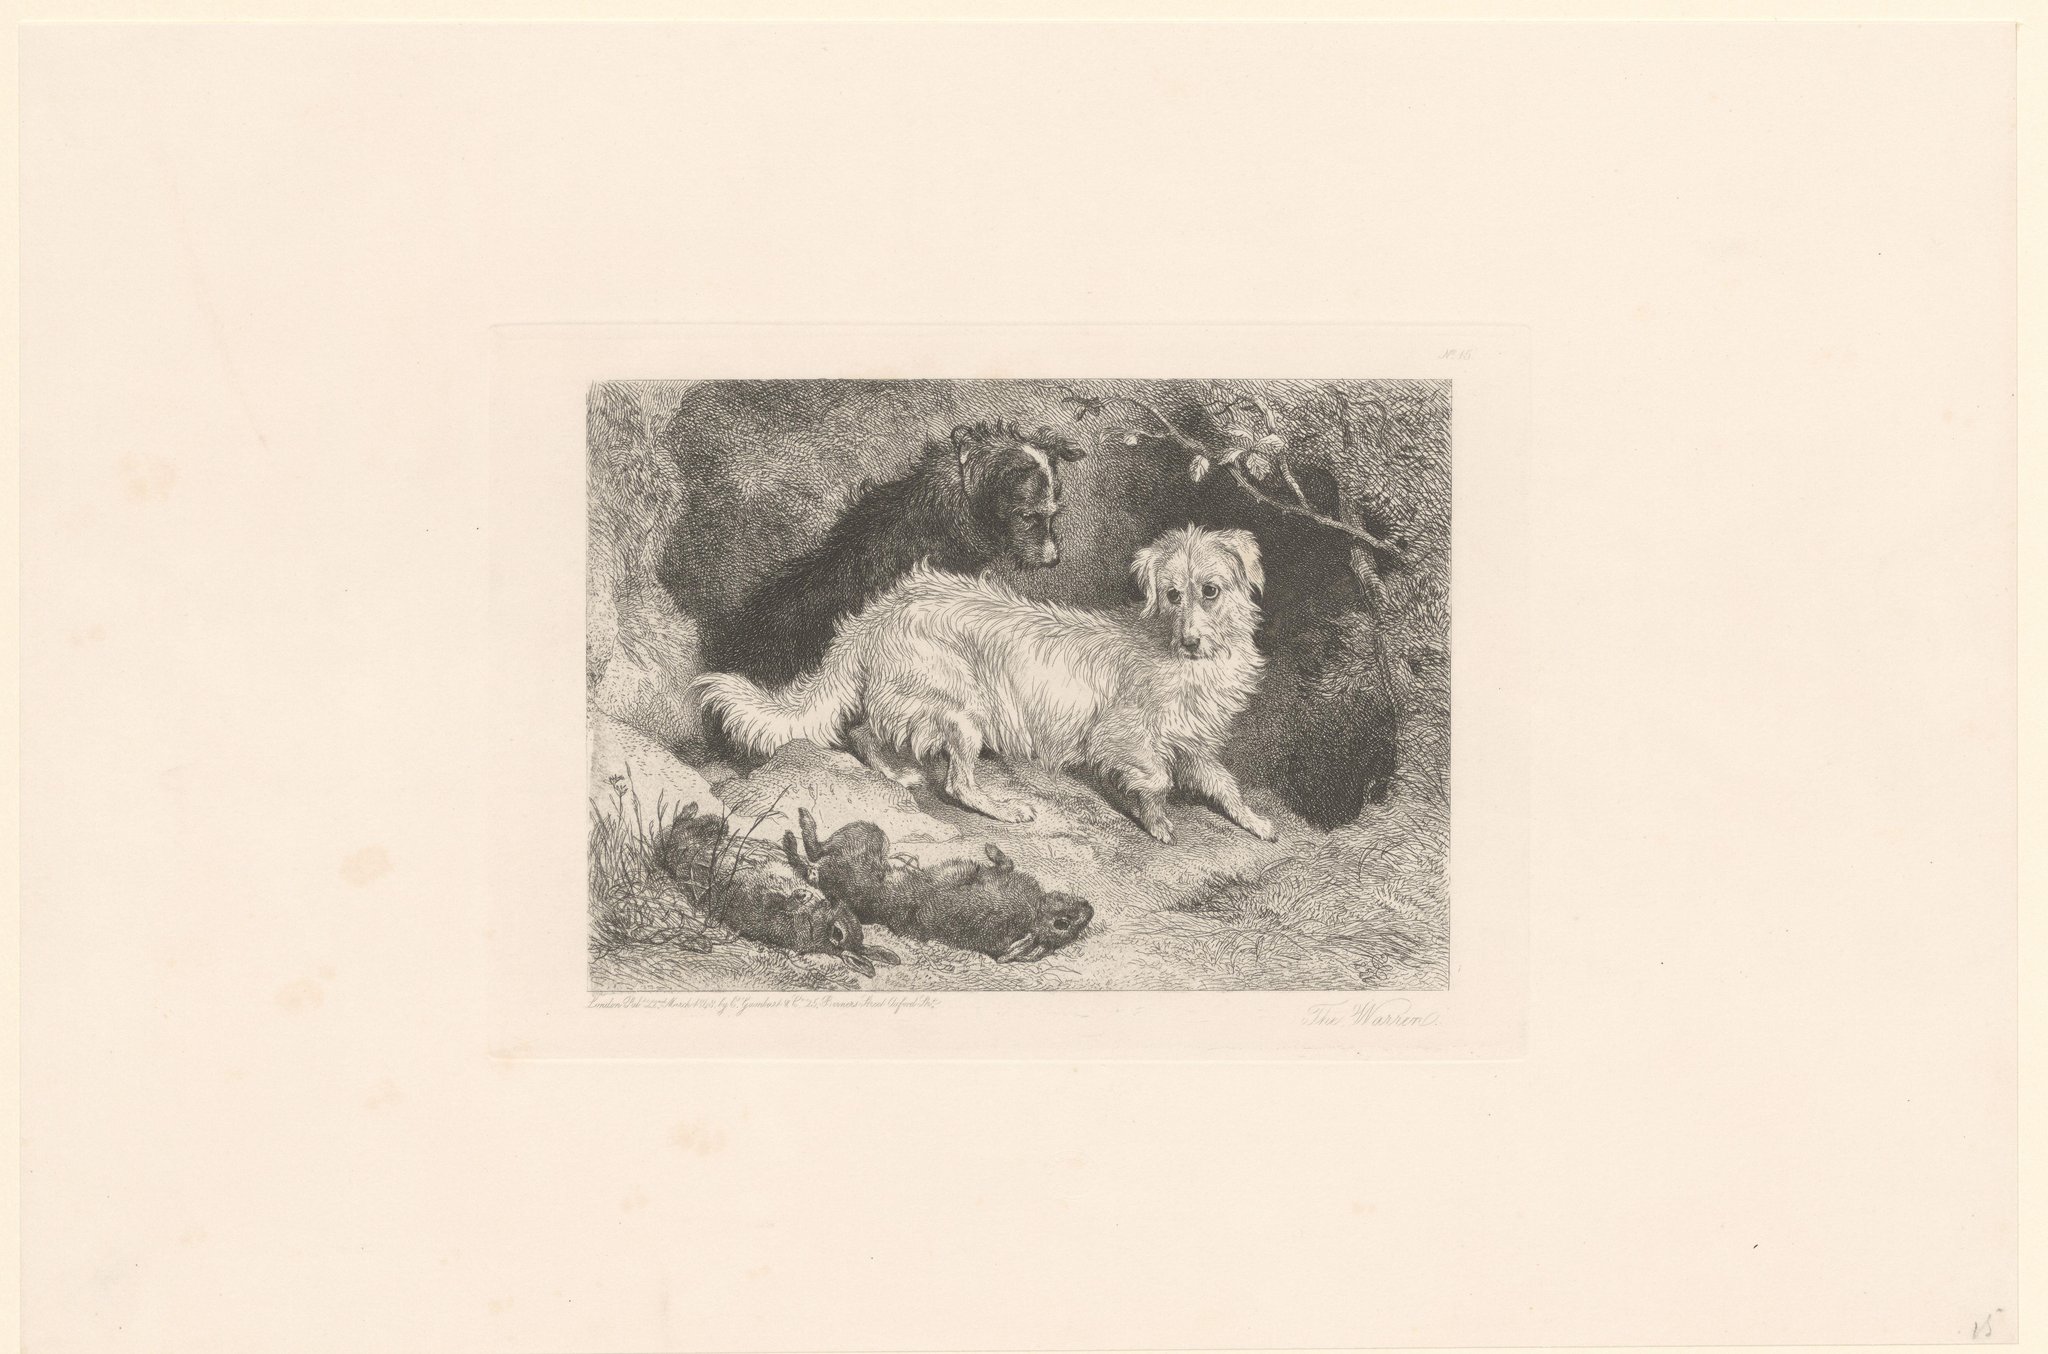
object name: print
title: The Warren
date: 1826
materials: paper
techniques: etching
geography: london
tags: wildlife reserve, national park, hunting dogs beside the spoils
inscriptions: collector's mark: Lugt 2228, check stamp: Lugt 4736